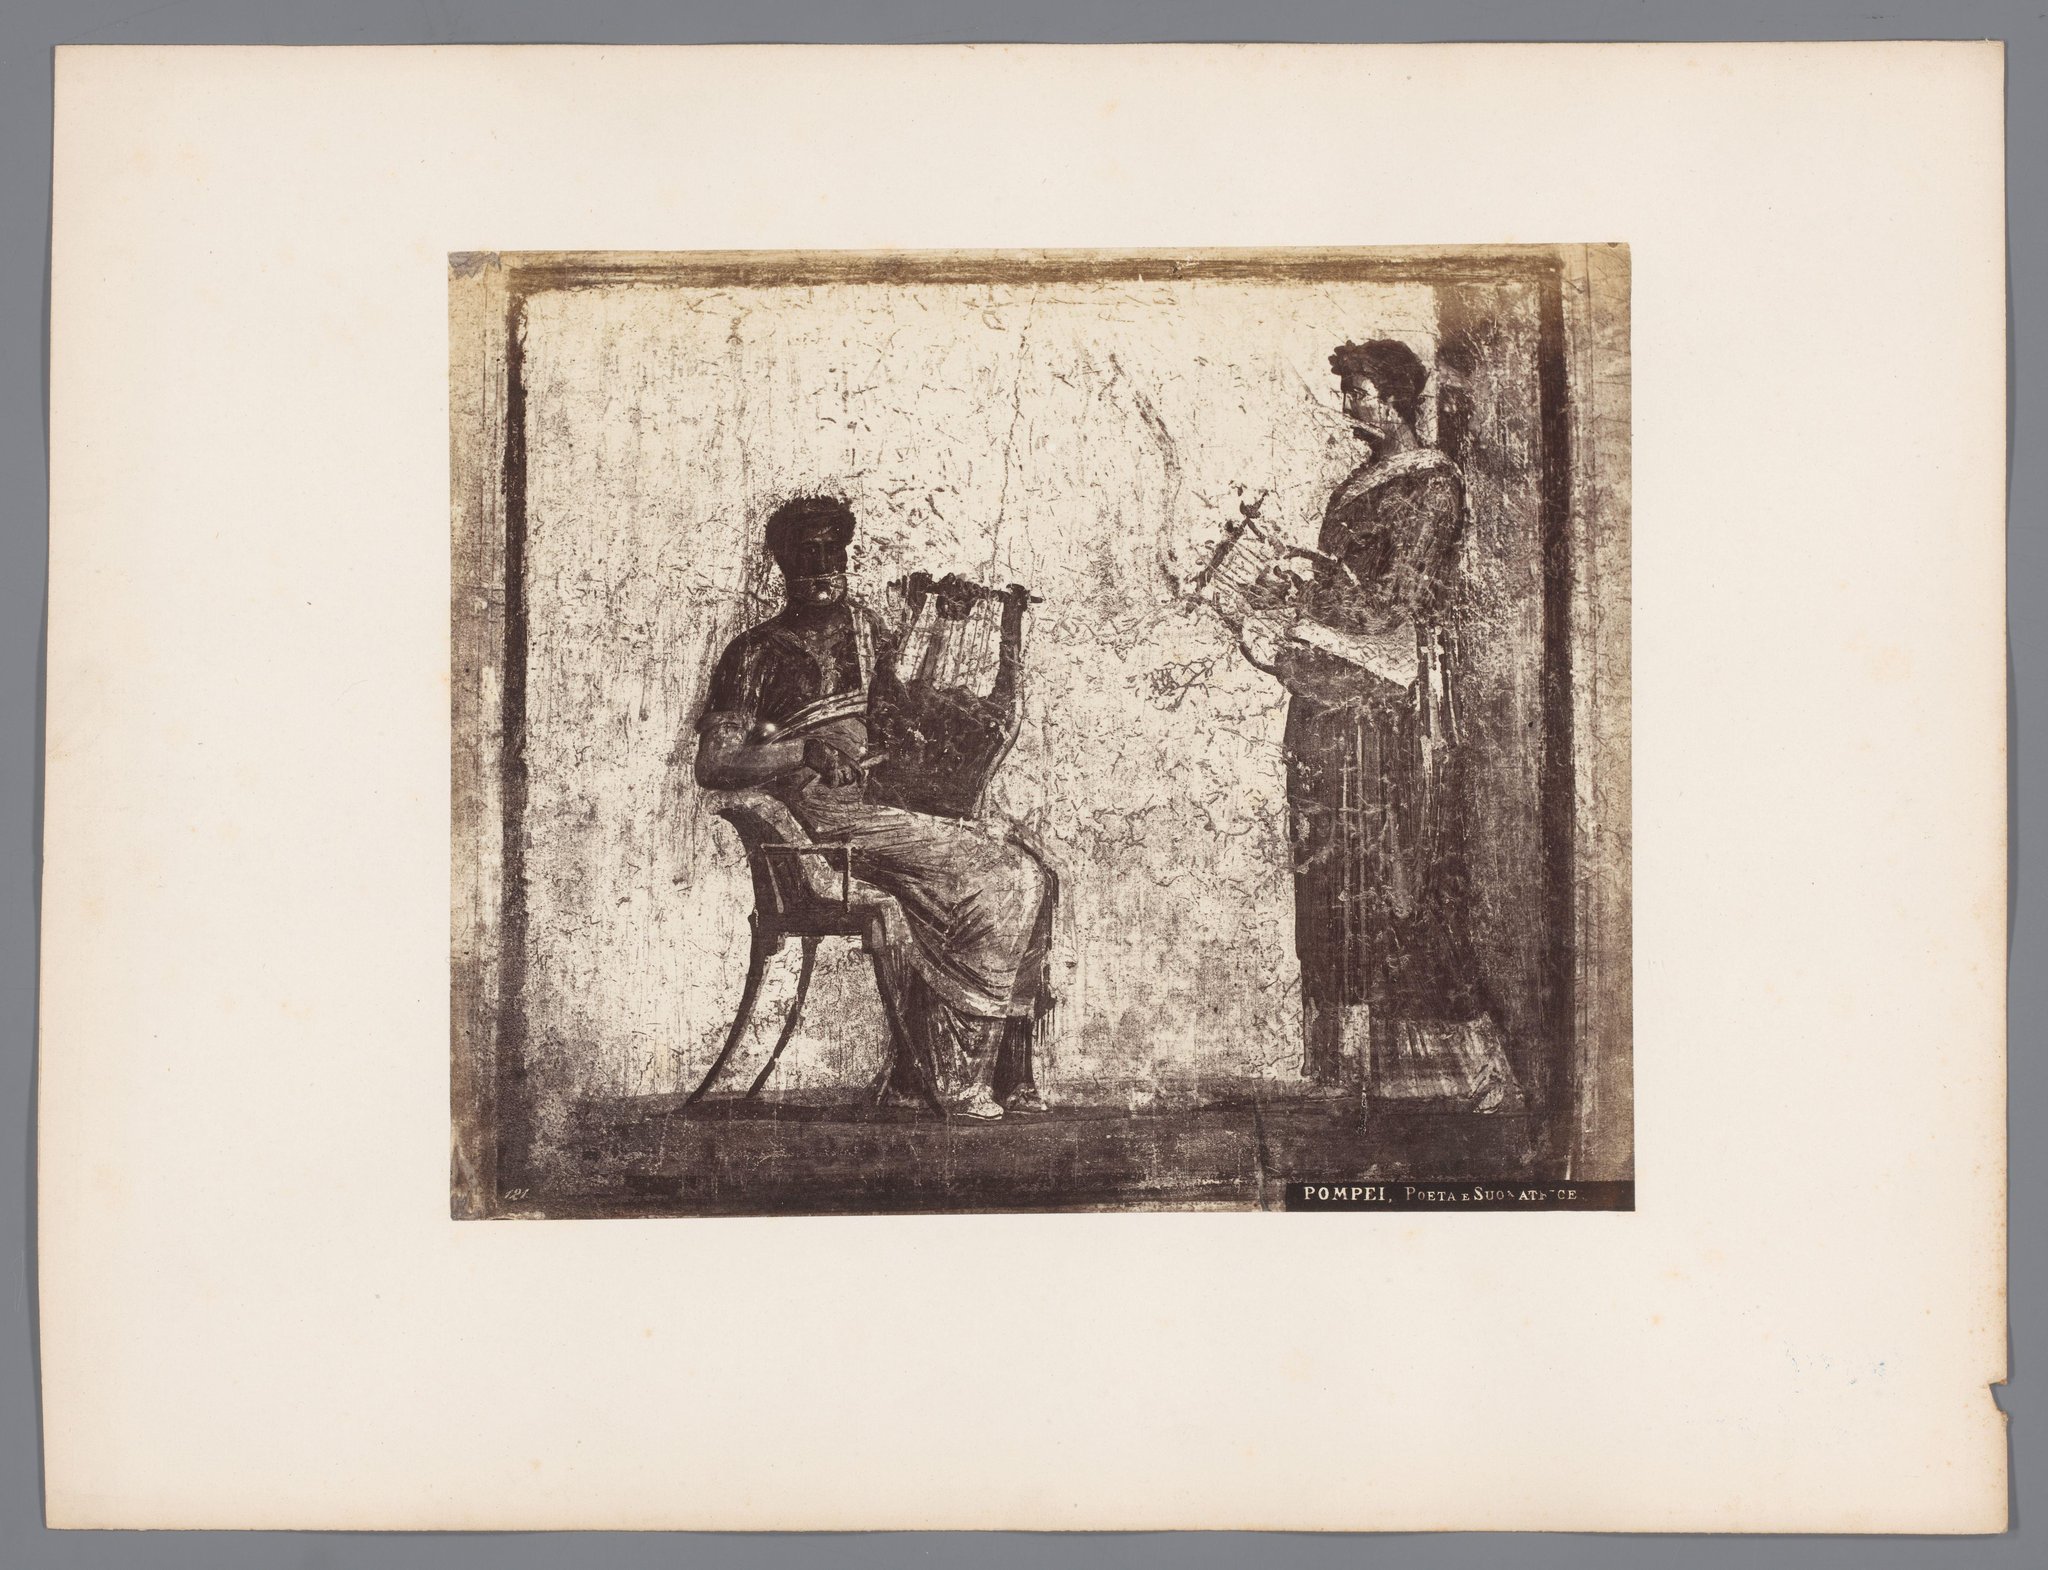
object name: reproduction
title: Pompei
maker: Anonymous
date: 1851-1900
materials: cardboard, paper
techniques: albumen print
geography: pompeii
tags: picture, painting, wall-covering, pompeii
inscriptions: number: ‘77’, number: ‘121’, number: ‘11’